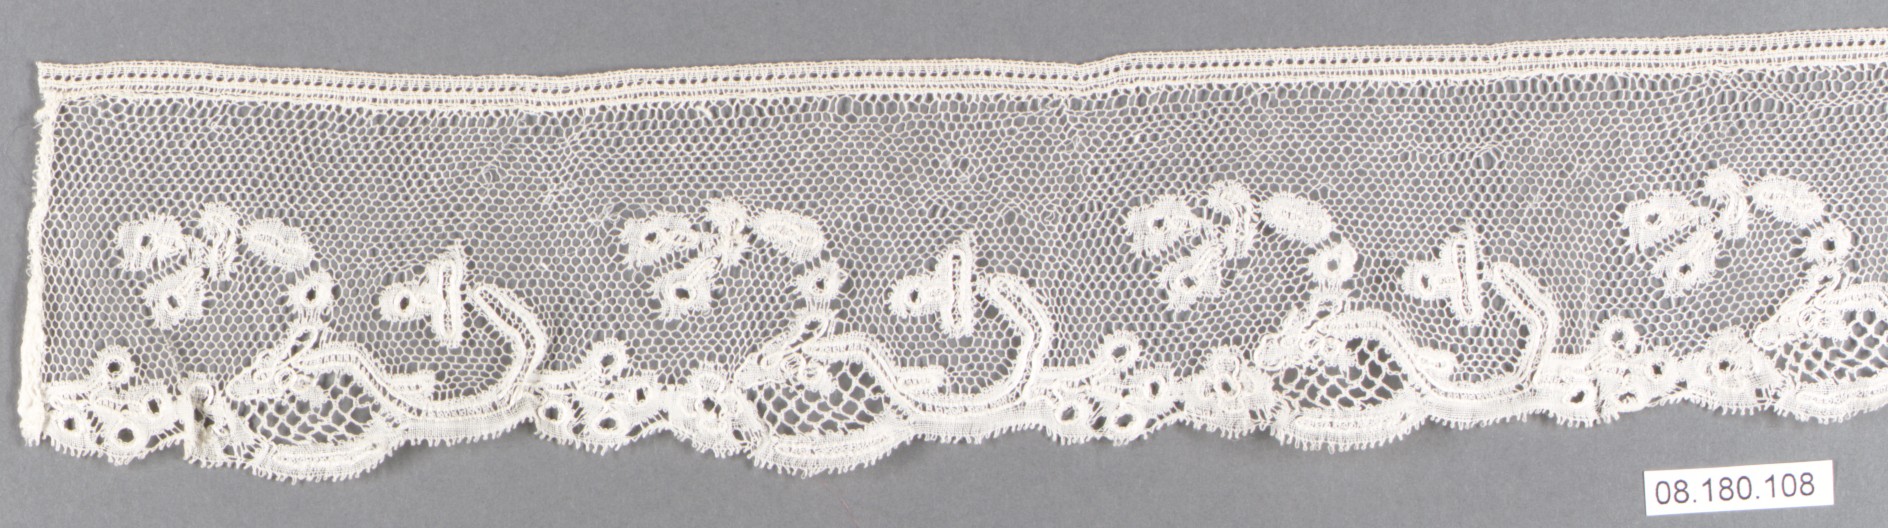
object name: fragment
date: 1801-1900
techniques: lace